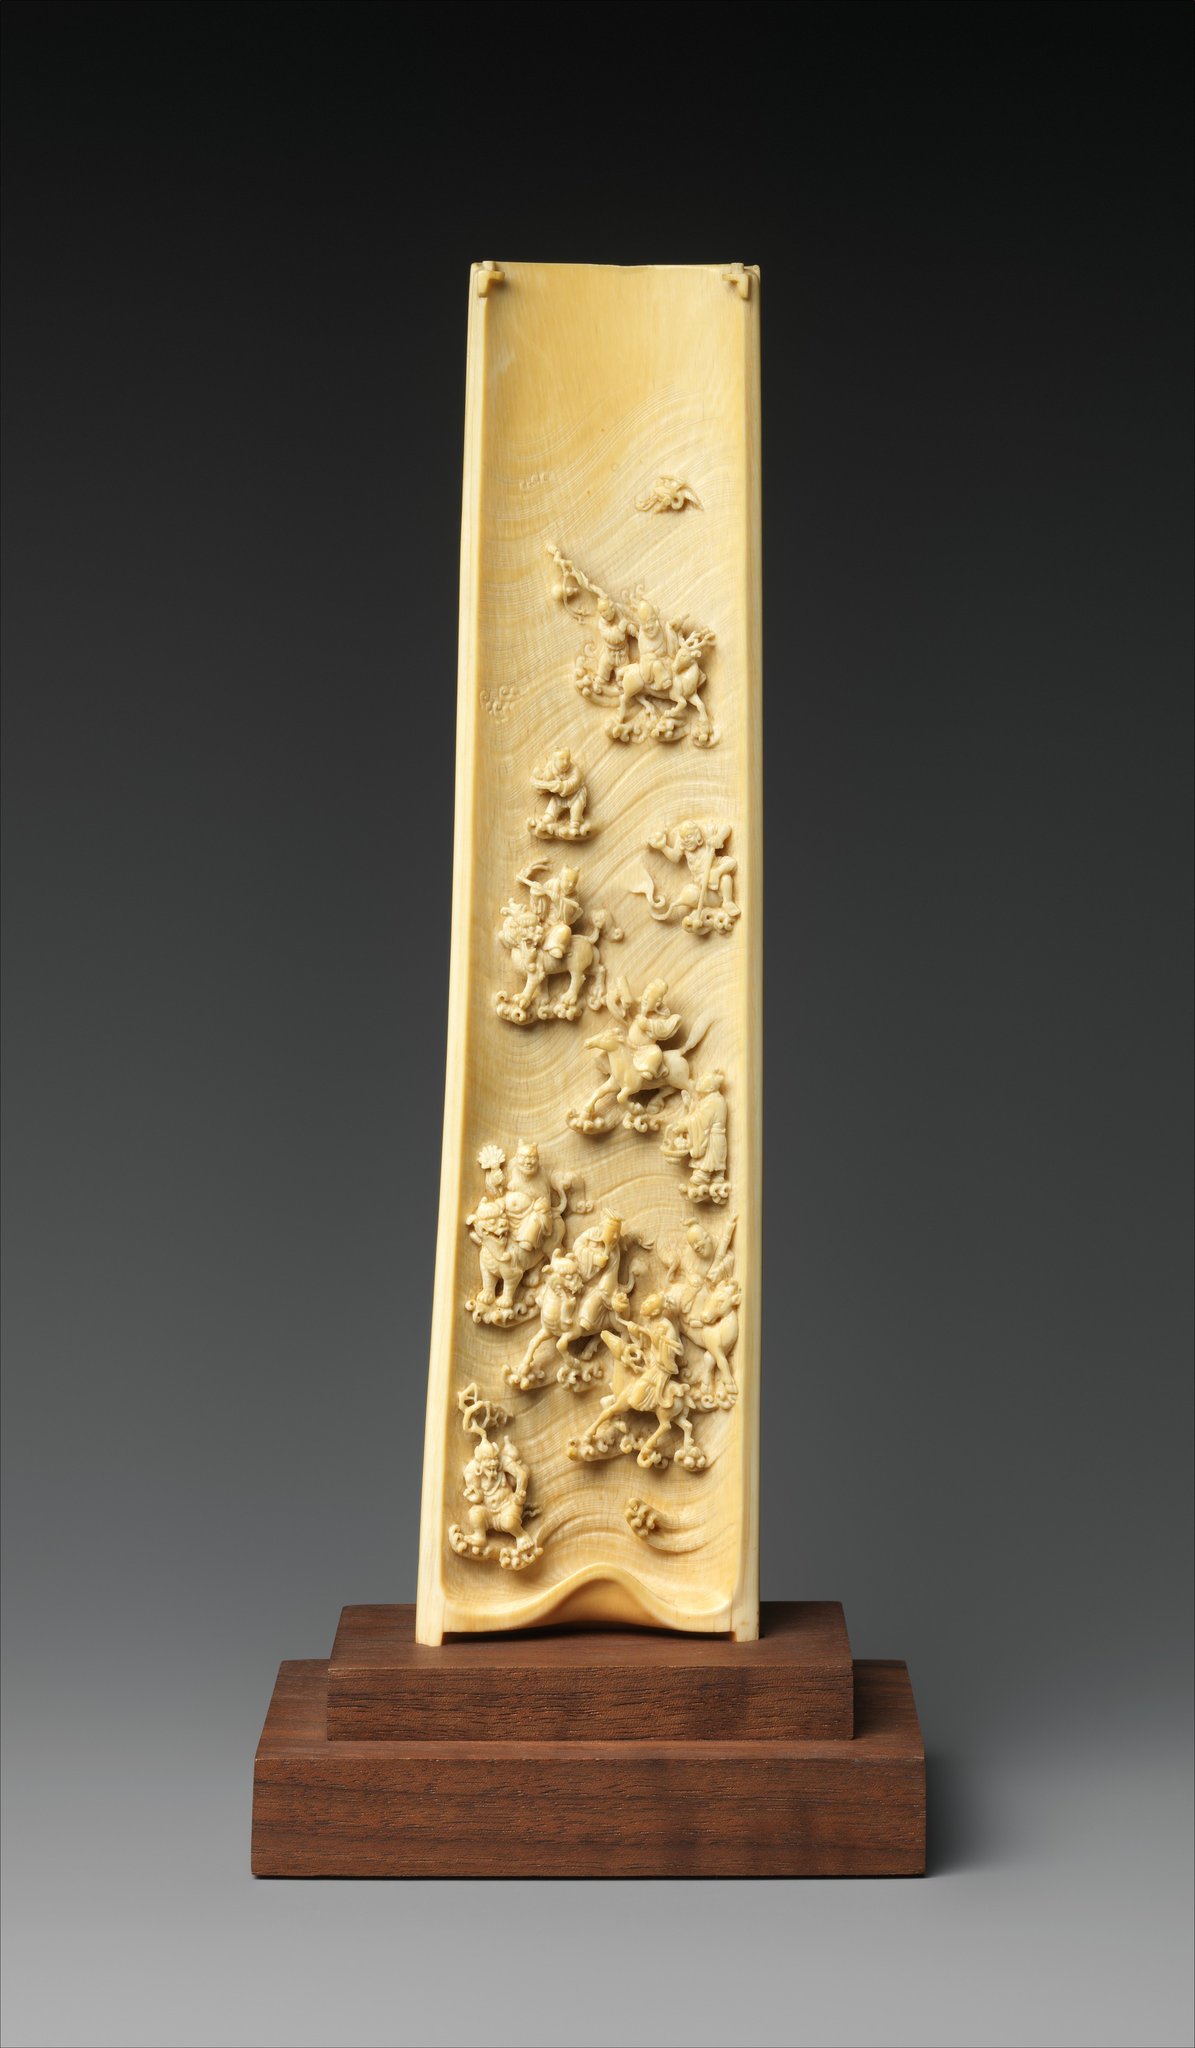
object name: wrist rest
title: Wrist rest with seascape and eight immortals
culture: chinese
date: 1701-1800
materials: ivory